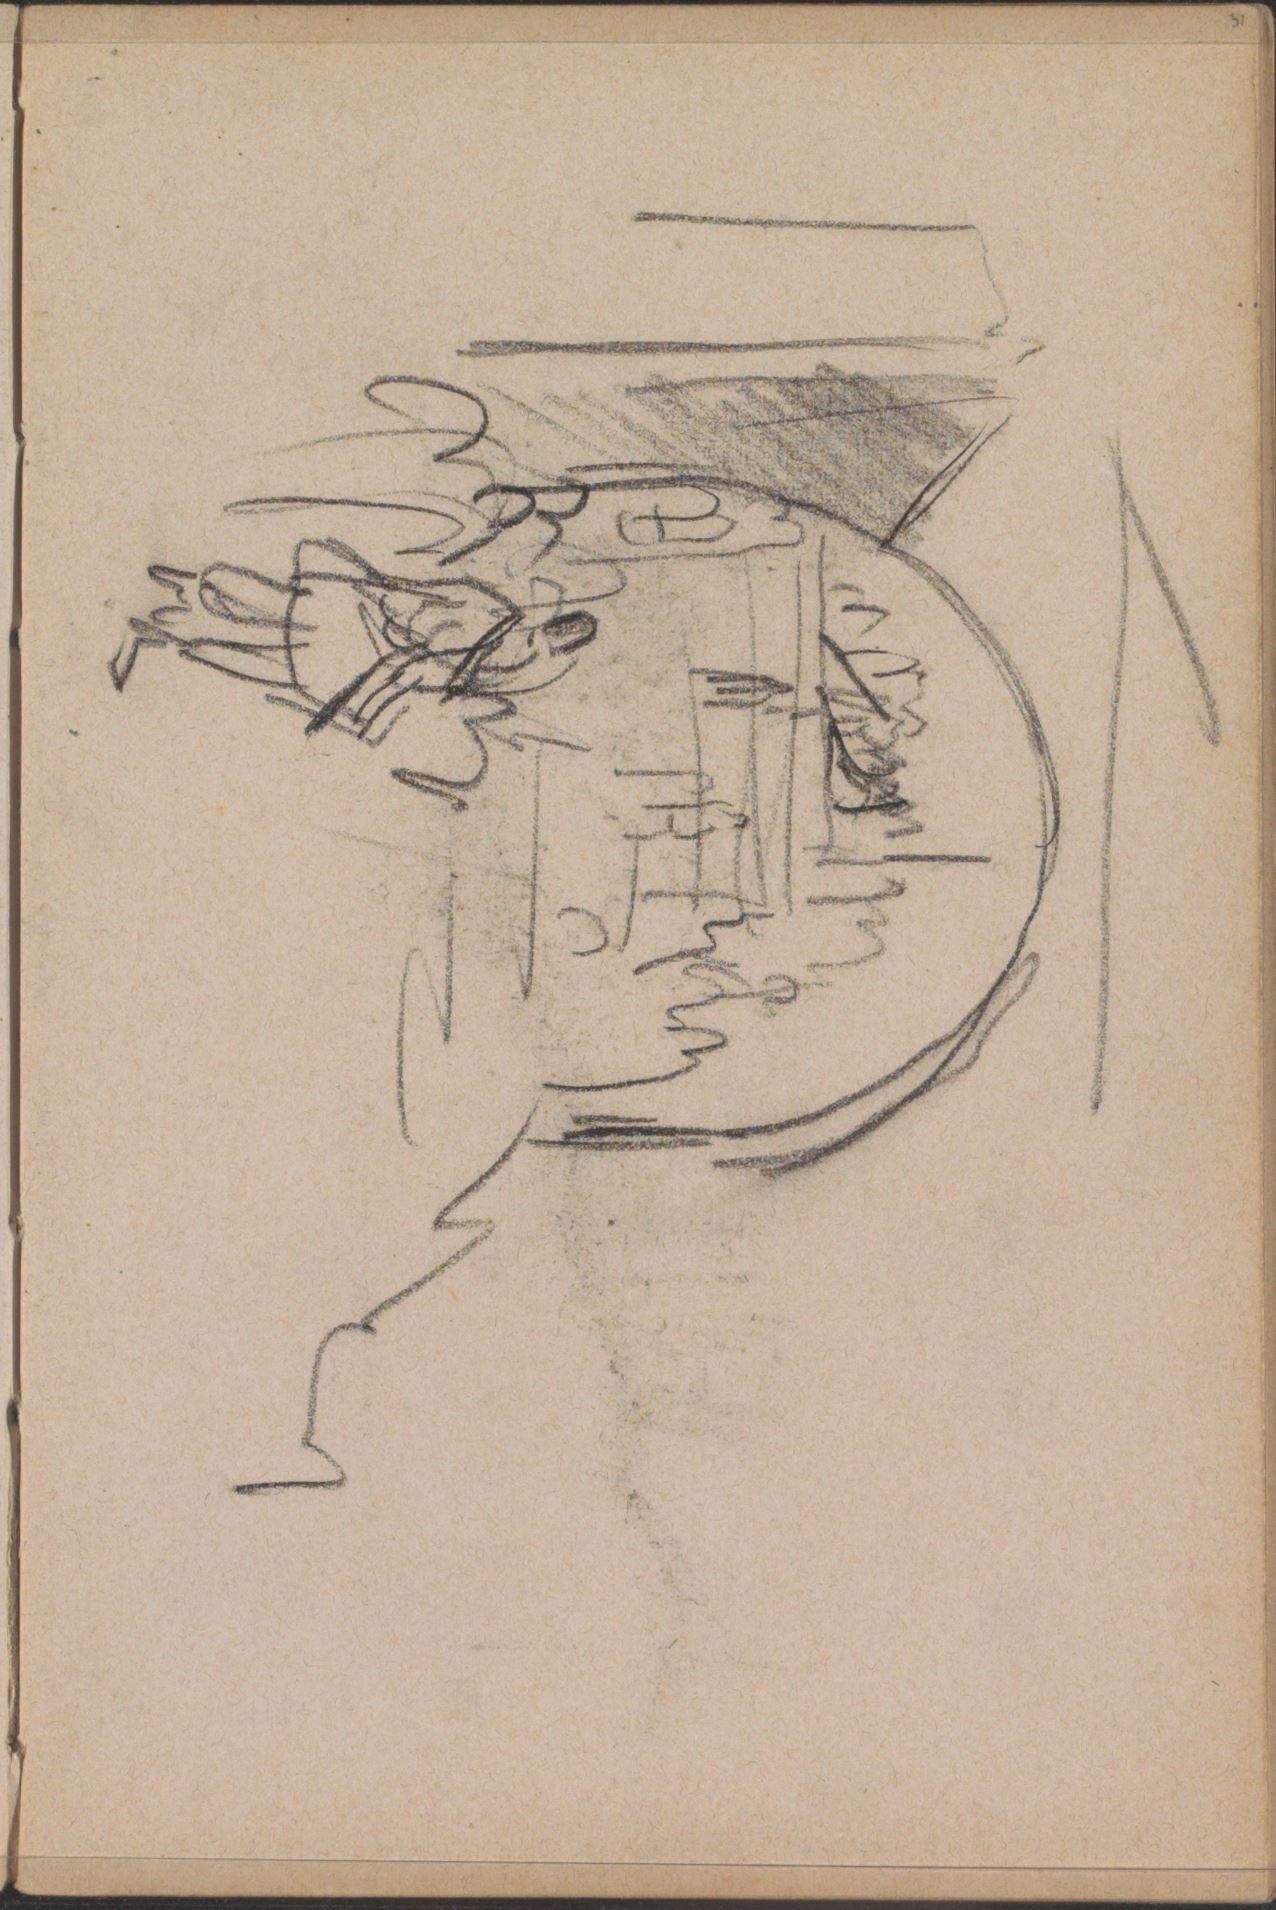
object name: sketchbook leaf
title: Figuren bij de trap van de Rode Veranda van het Granovitaya Palata te Moskou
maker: marius bauer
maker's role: draughtsman, print maker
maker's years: 1867-1932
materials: chalk, paper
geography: moscow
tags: flight of steps, arch, archivolt ~ architecture, palace, (military) uniforms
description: De trap en veranda maakten deel uit van de route van de processie voor tsaar Nicolaas II. Op de voorgrond een figuur in militair kostuum. Pagina 31 uit een schetsboek met 54 bladen.